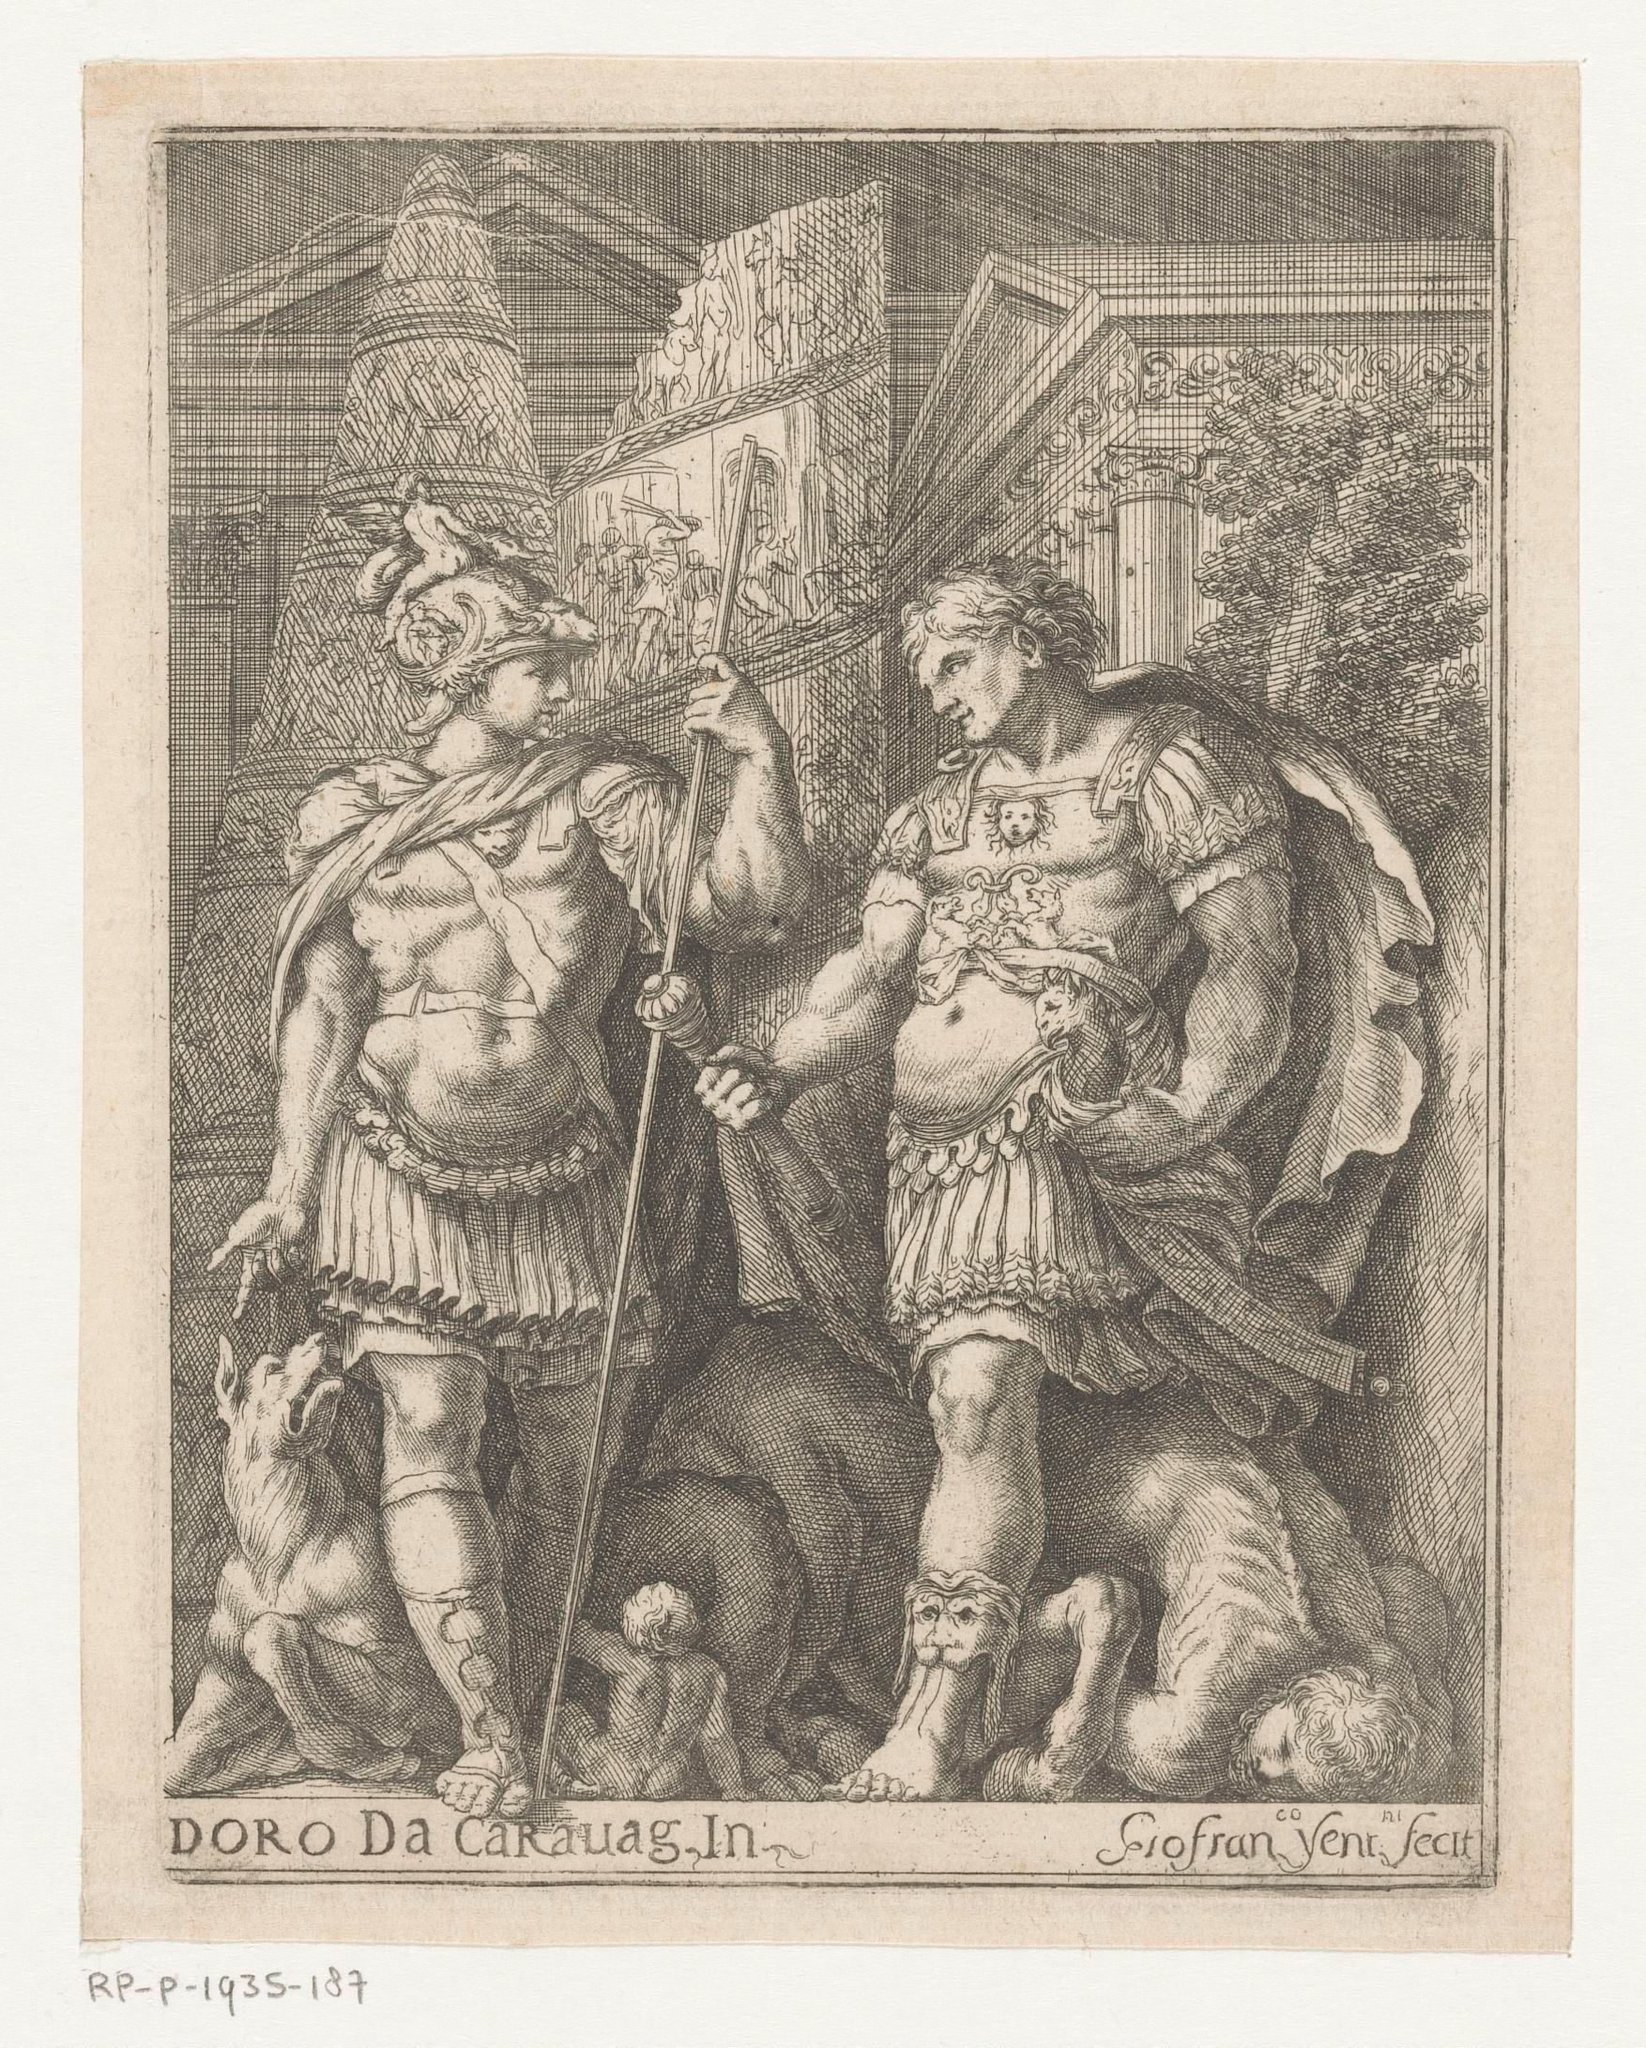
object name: print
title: Twee soldaten in een stad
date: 1660-1710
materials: paper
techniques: engraving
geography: italy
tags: city-view in general; 'veduta', romulus and remus are washed ashore and suckled by a she-wolf; 'lupa romana'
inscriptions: collector's mark: Lugt 2228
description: Op de voorgrond twee soldaten. Linksonder de wolvin door wie Romulus en Remus werden gevonden en gezoogd. Op de achtergrond gebouwen.